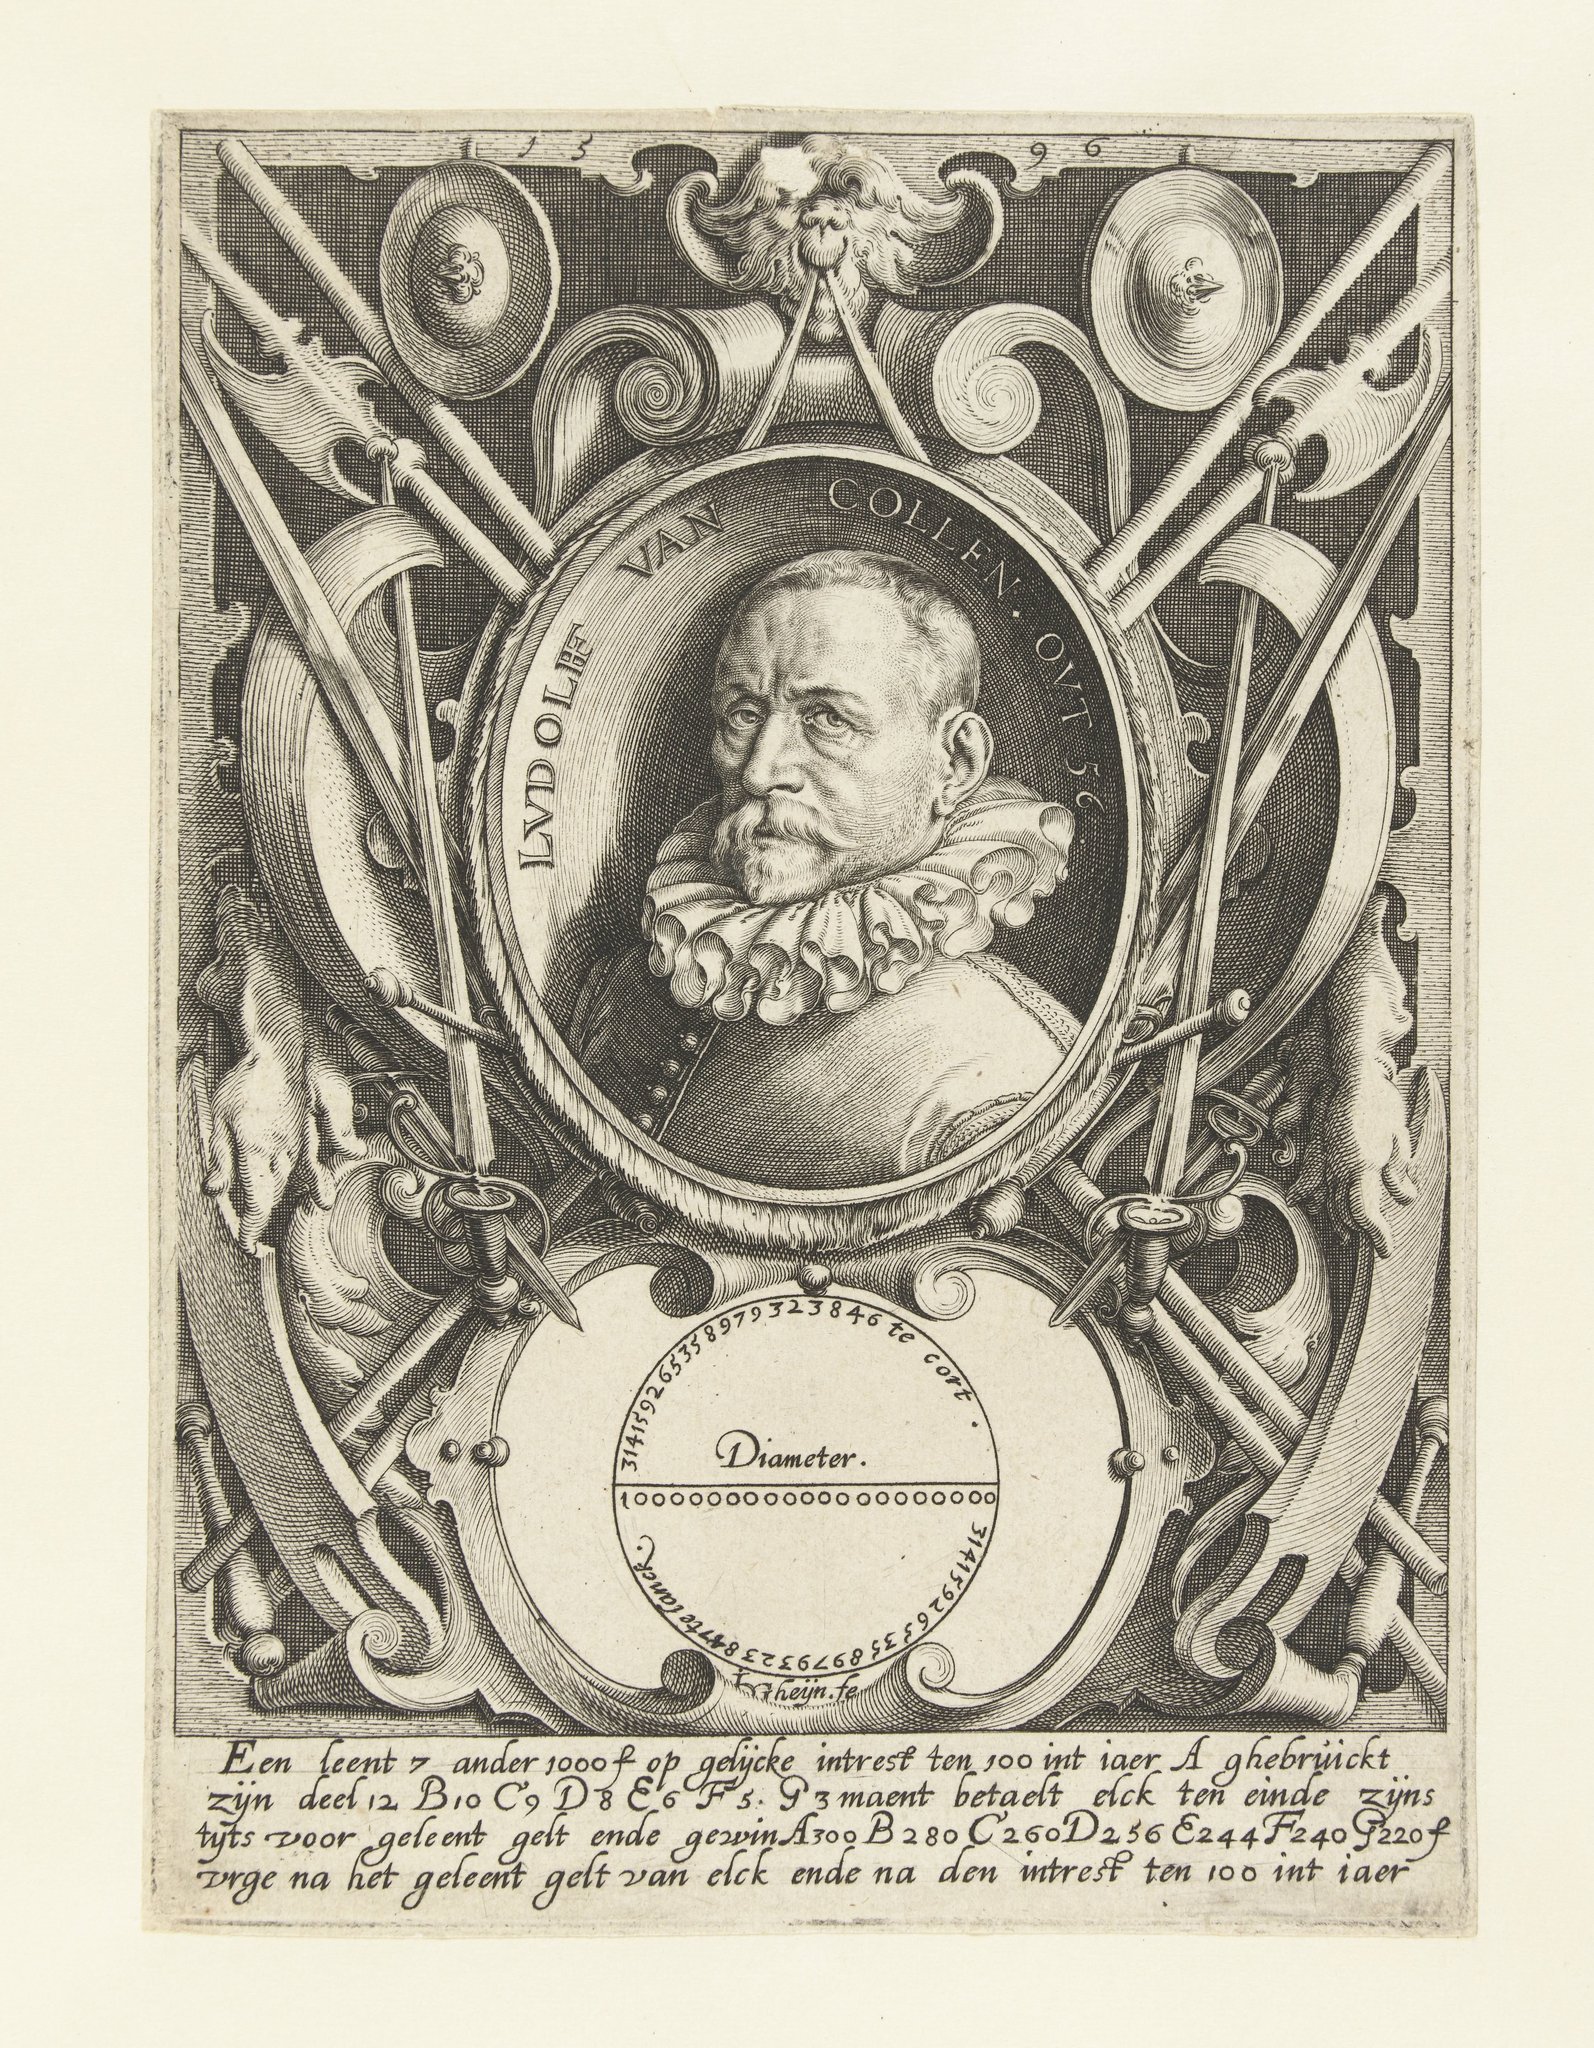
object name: print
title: Portret van Ludolf van Ceulen op 56-jarige leeftijd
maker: jacques de gheyn (ii)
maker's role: painter, print maker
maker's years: 1565-1629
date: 1596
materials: paper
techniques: engraving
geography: leiden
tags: historical persons, mathematics (+ portrait of scholar, scientist)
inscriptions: collector's mark: Lugt 240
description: Buste van Ludolf van Ceulen (Hildesheim, 28 januari 1540 - Leiden, 31 december 1610) op 56-jarige leeftijd, met losgeplooide kraag, in ovaal met randschrift, gevat in ornamentlijst met rolwerk en wapens. Onder het portret een afbeelding van een cirkel met een beschrijving van het getal pi. Onder de voorstelling een vierregelig Nederlands onderschrift. Van Ceulen was schermer en mathematicus. Hij werd (volgens Meursius in 1599, volgens de resoluties van Curatoren op 10 januari 1600) op aanbeveling van prins Maurits samen met Simon Fransz. van Merwen benoemd tot professor in de 'Nederduytsche mathematicque' in Leiden. Berekende het getal pi (de verhouding tussen de omtrek en de middellijn van een cirkel) in 35 decimalen.